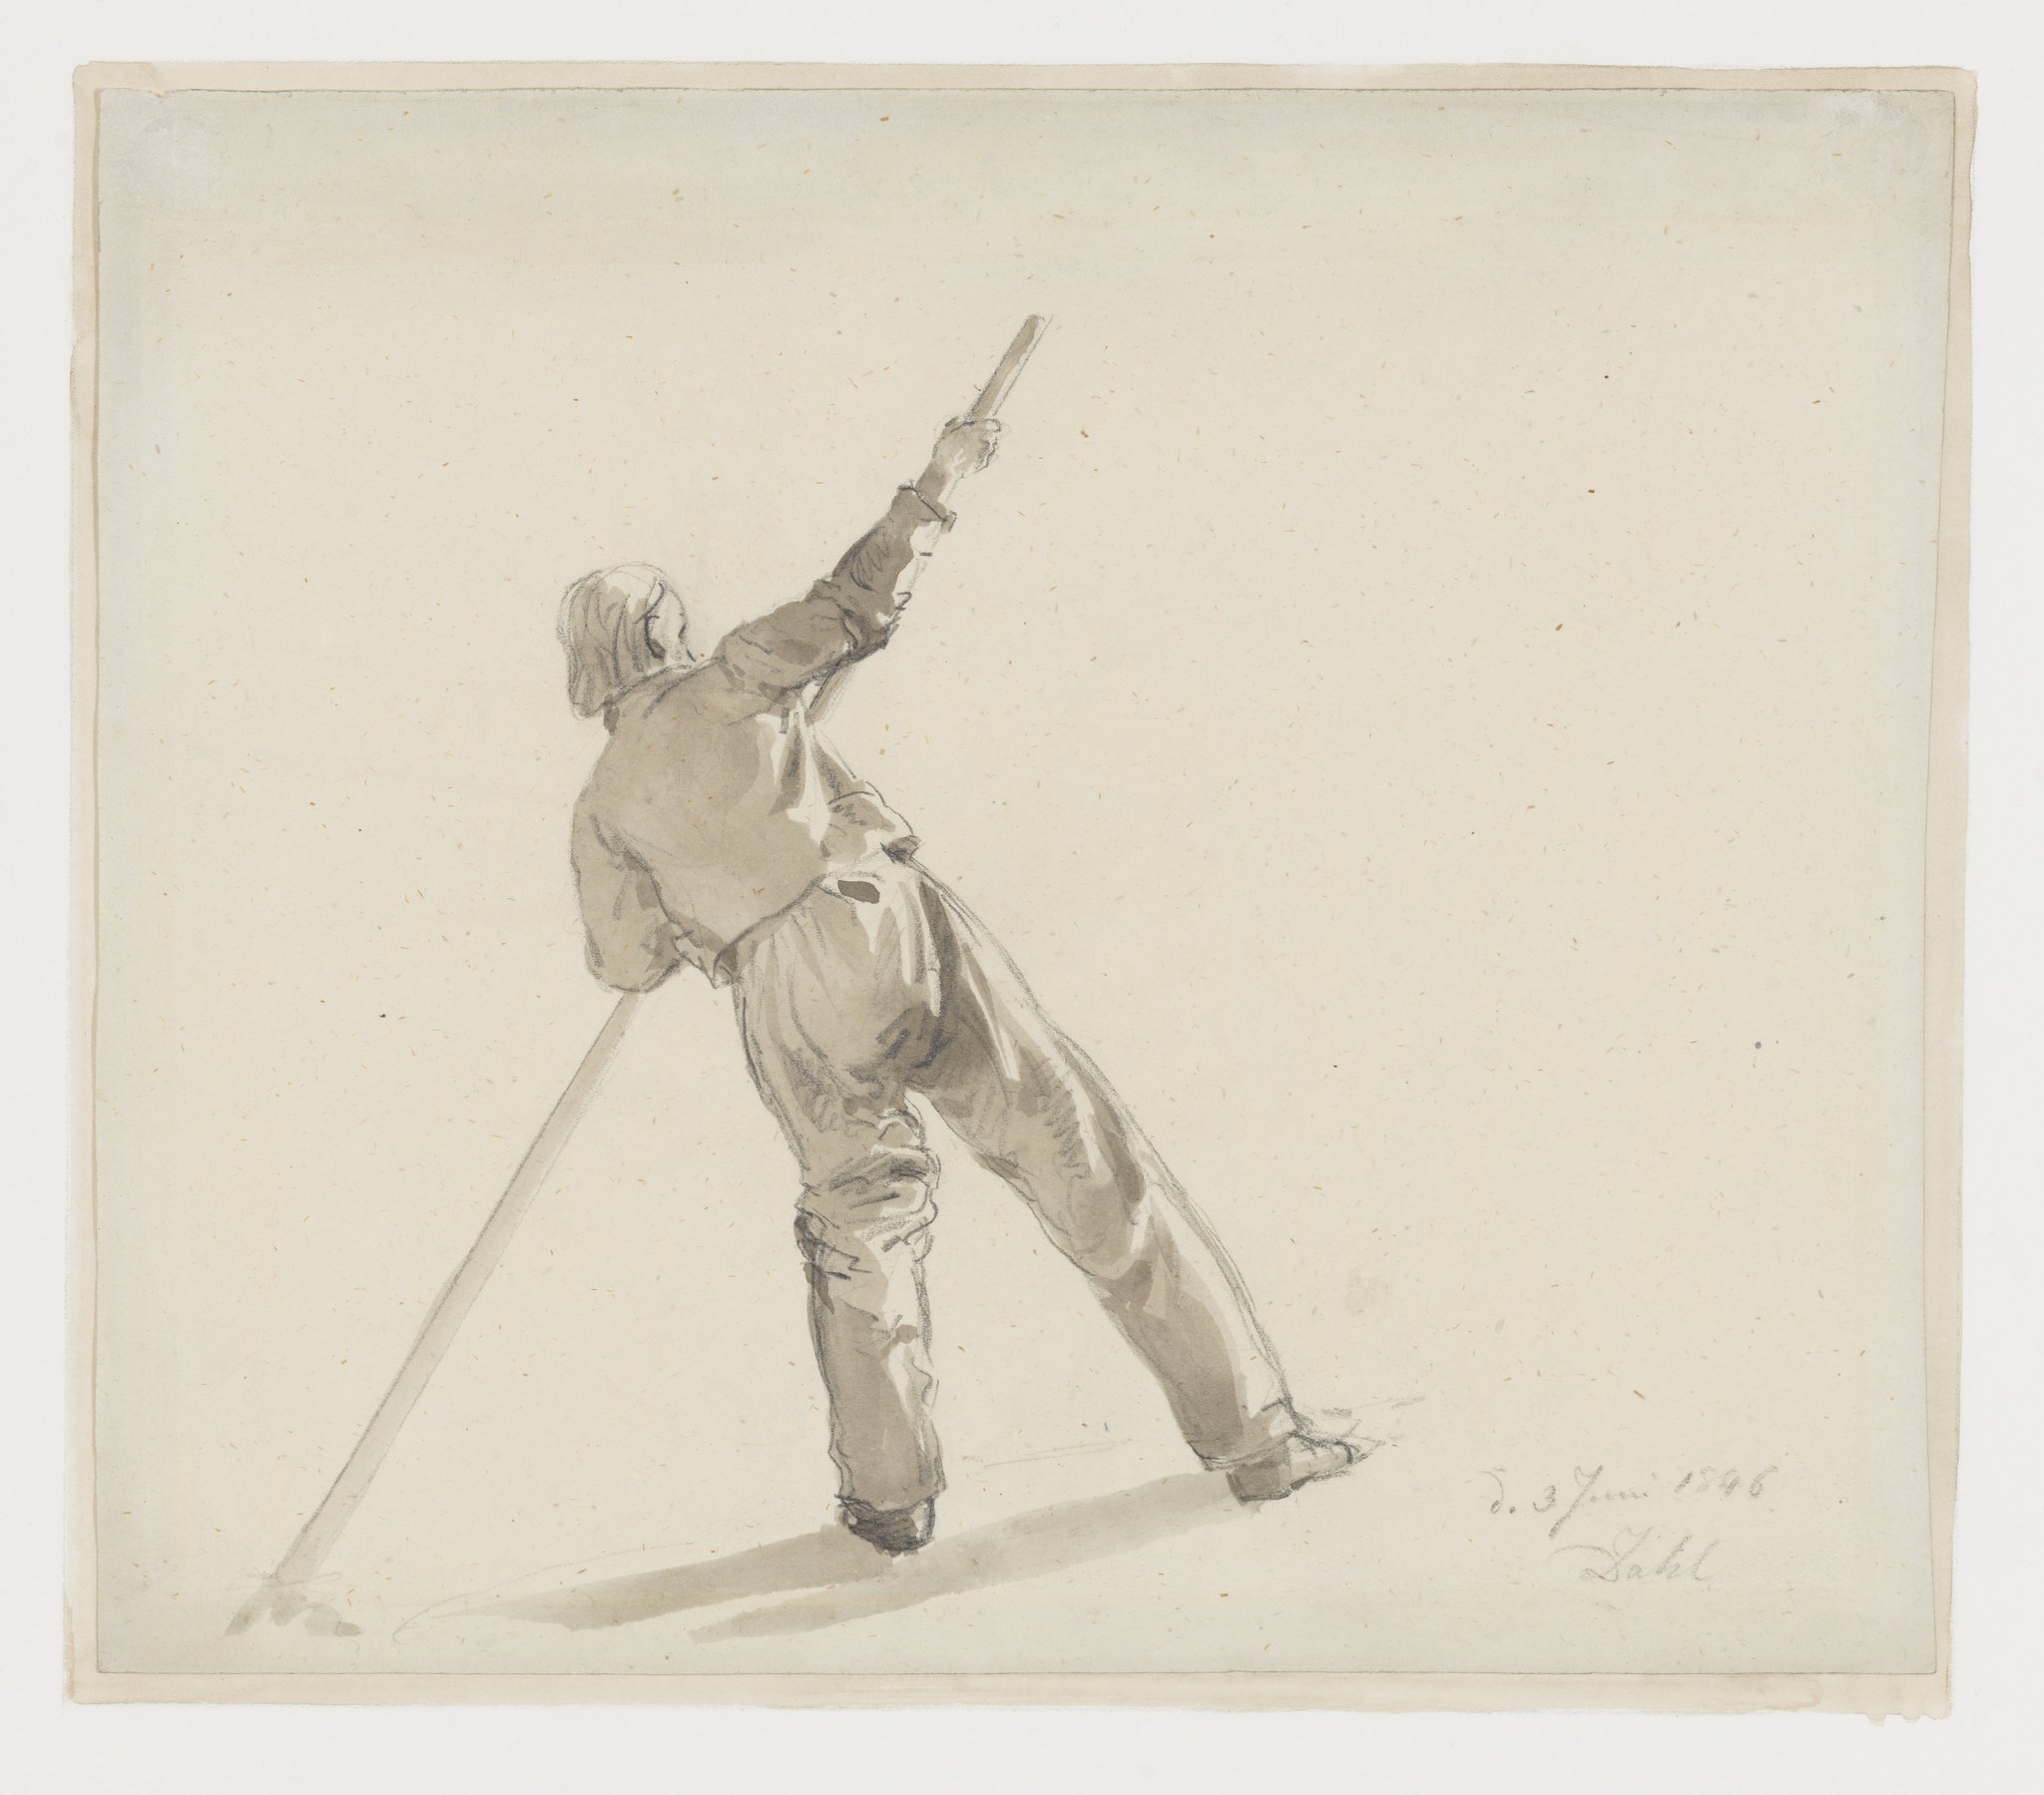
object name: drawing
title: A man holding an oar (study for the painting "Copenhagen Harbor by Moonlight")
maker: johan christian dahl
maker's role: artist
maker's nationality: norwegian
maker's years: 1788-1857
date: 1846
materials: graphite, paper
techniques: wash